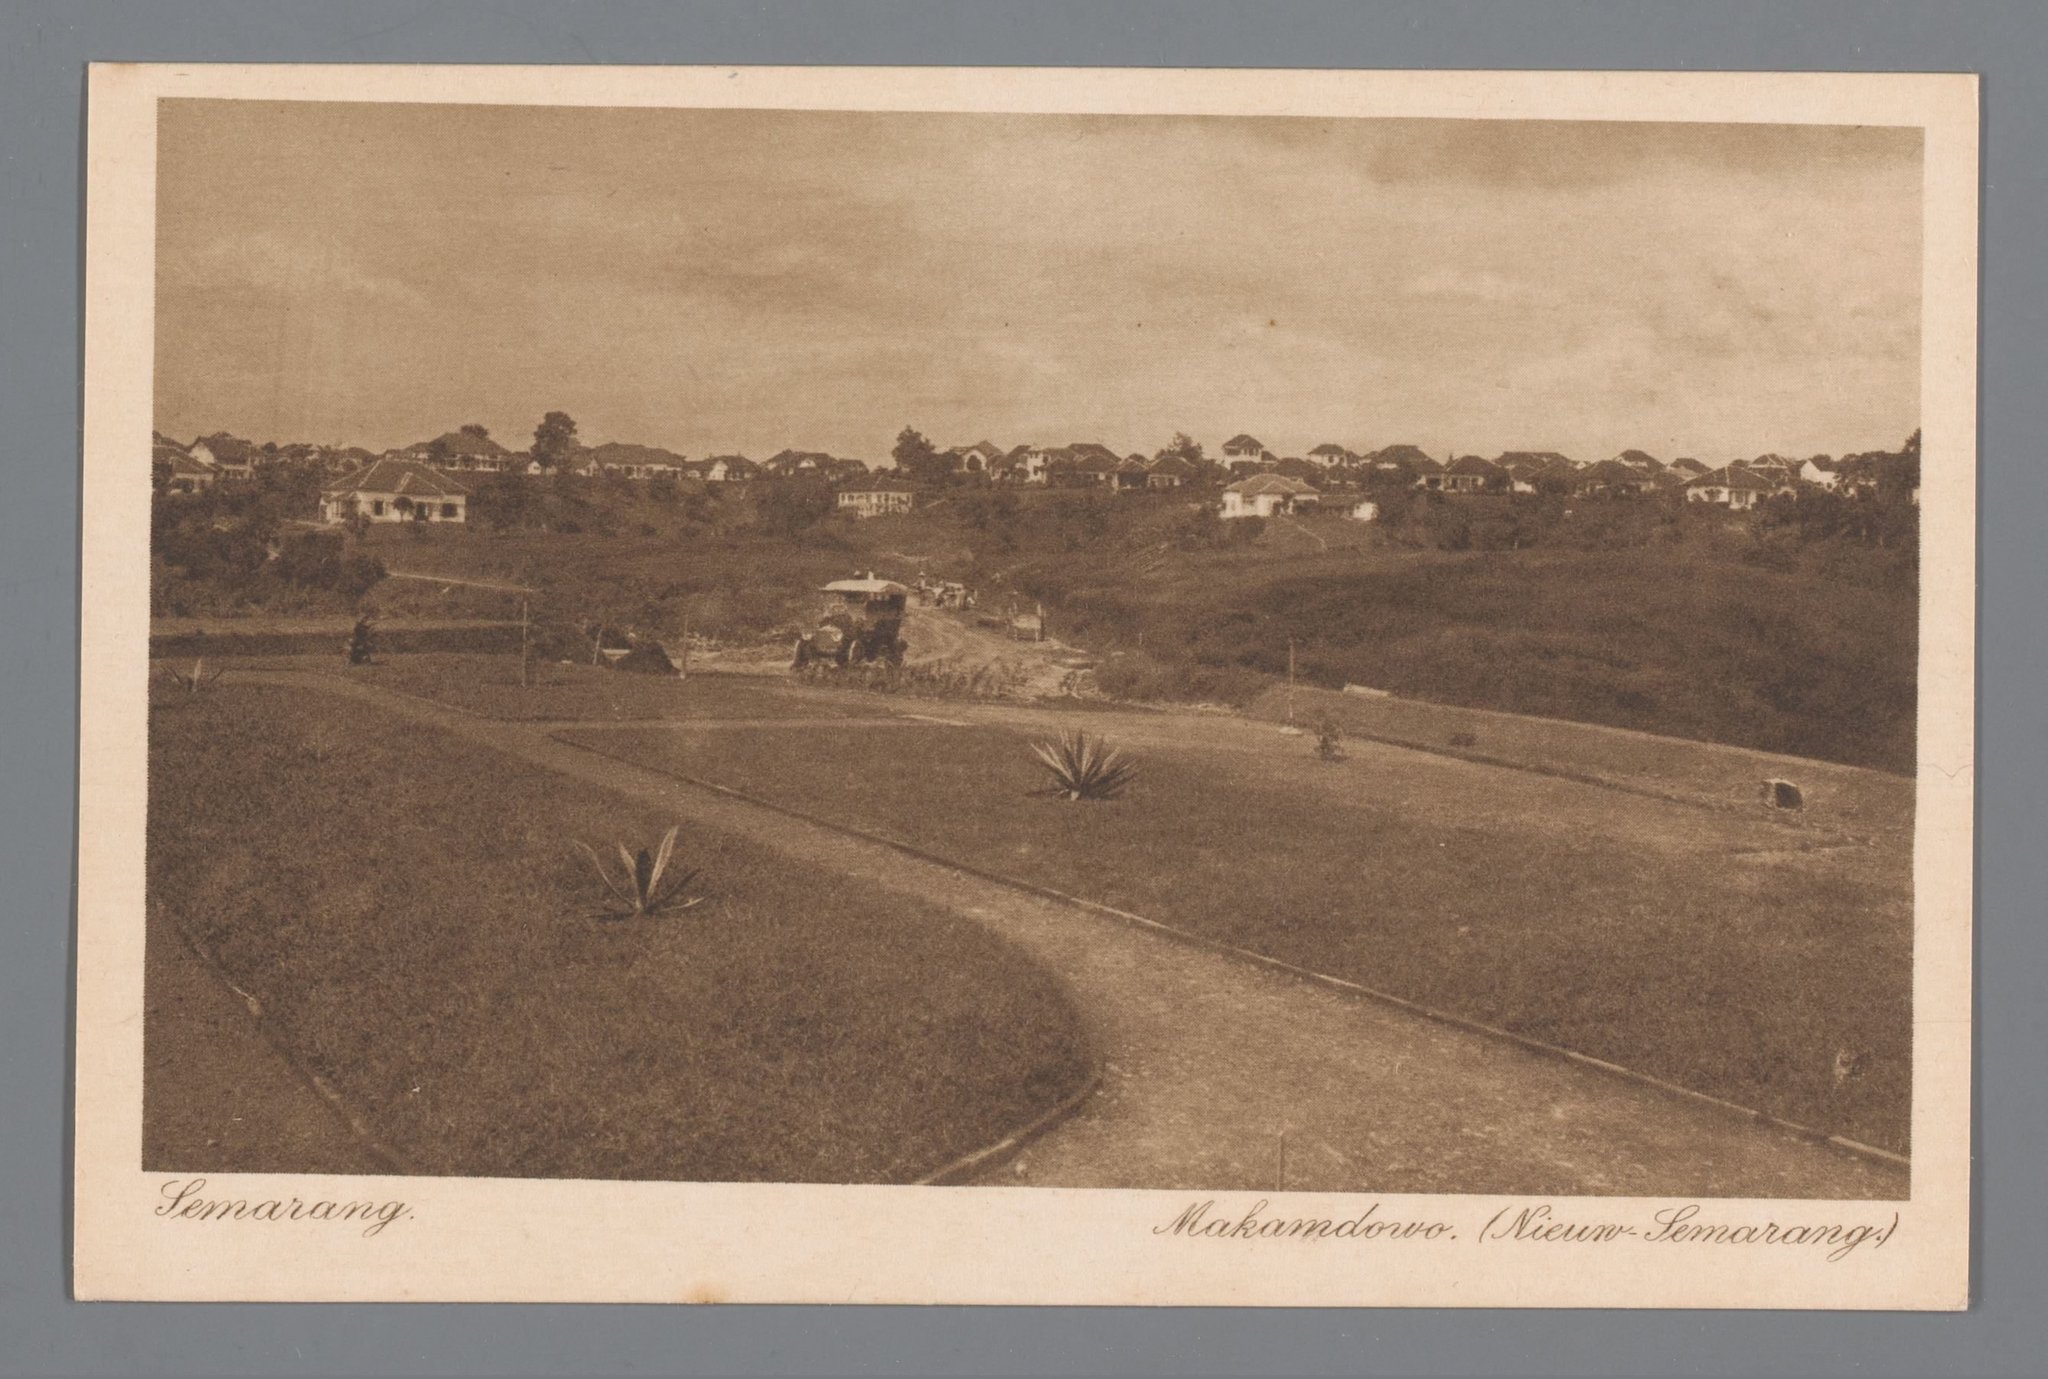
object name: photograph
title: Semarang. Makamdowo (Nieuw-Semarang)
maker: otto hisgen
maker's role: fotograaf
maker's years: 1874-1944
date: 1900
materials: paper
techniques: photography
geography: semarang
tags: dutch east indies, the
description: Eén van zes briefkaarten, foto's in bruin, stadsgezichten van Nieuw-Semarang; achterzijde onbeschreven. Semarang ligt op midden-Java. Opmerking: zie NG-1011-A t/m F.